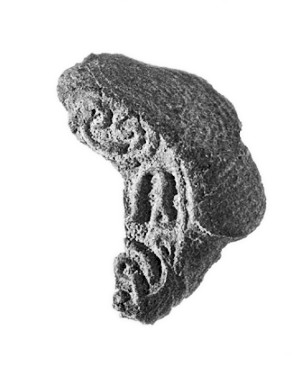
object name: sealing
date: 1981-1640 BCE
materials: mud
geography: egypt